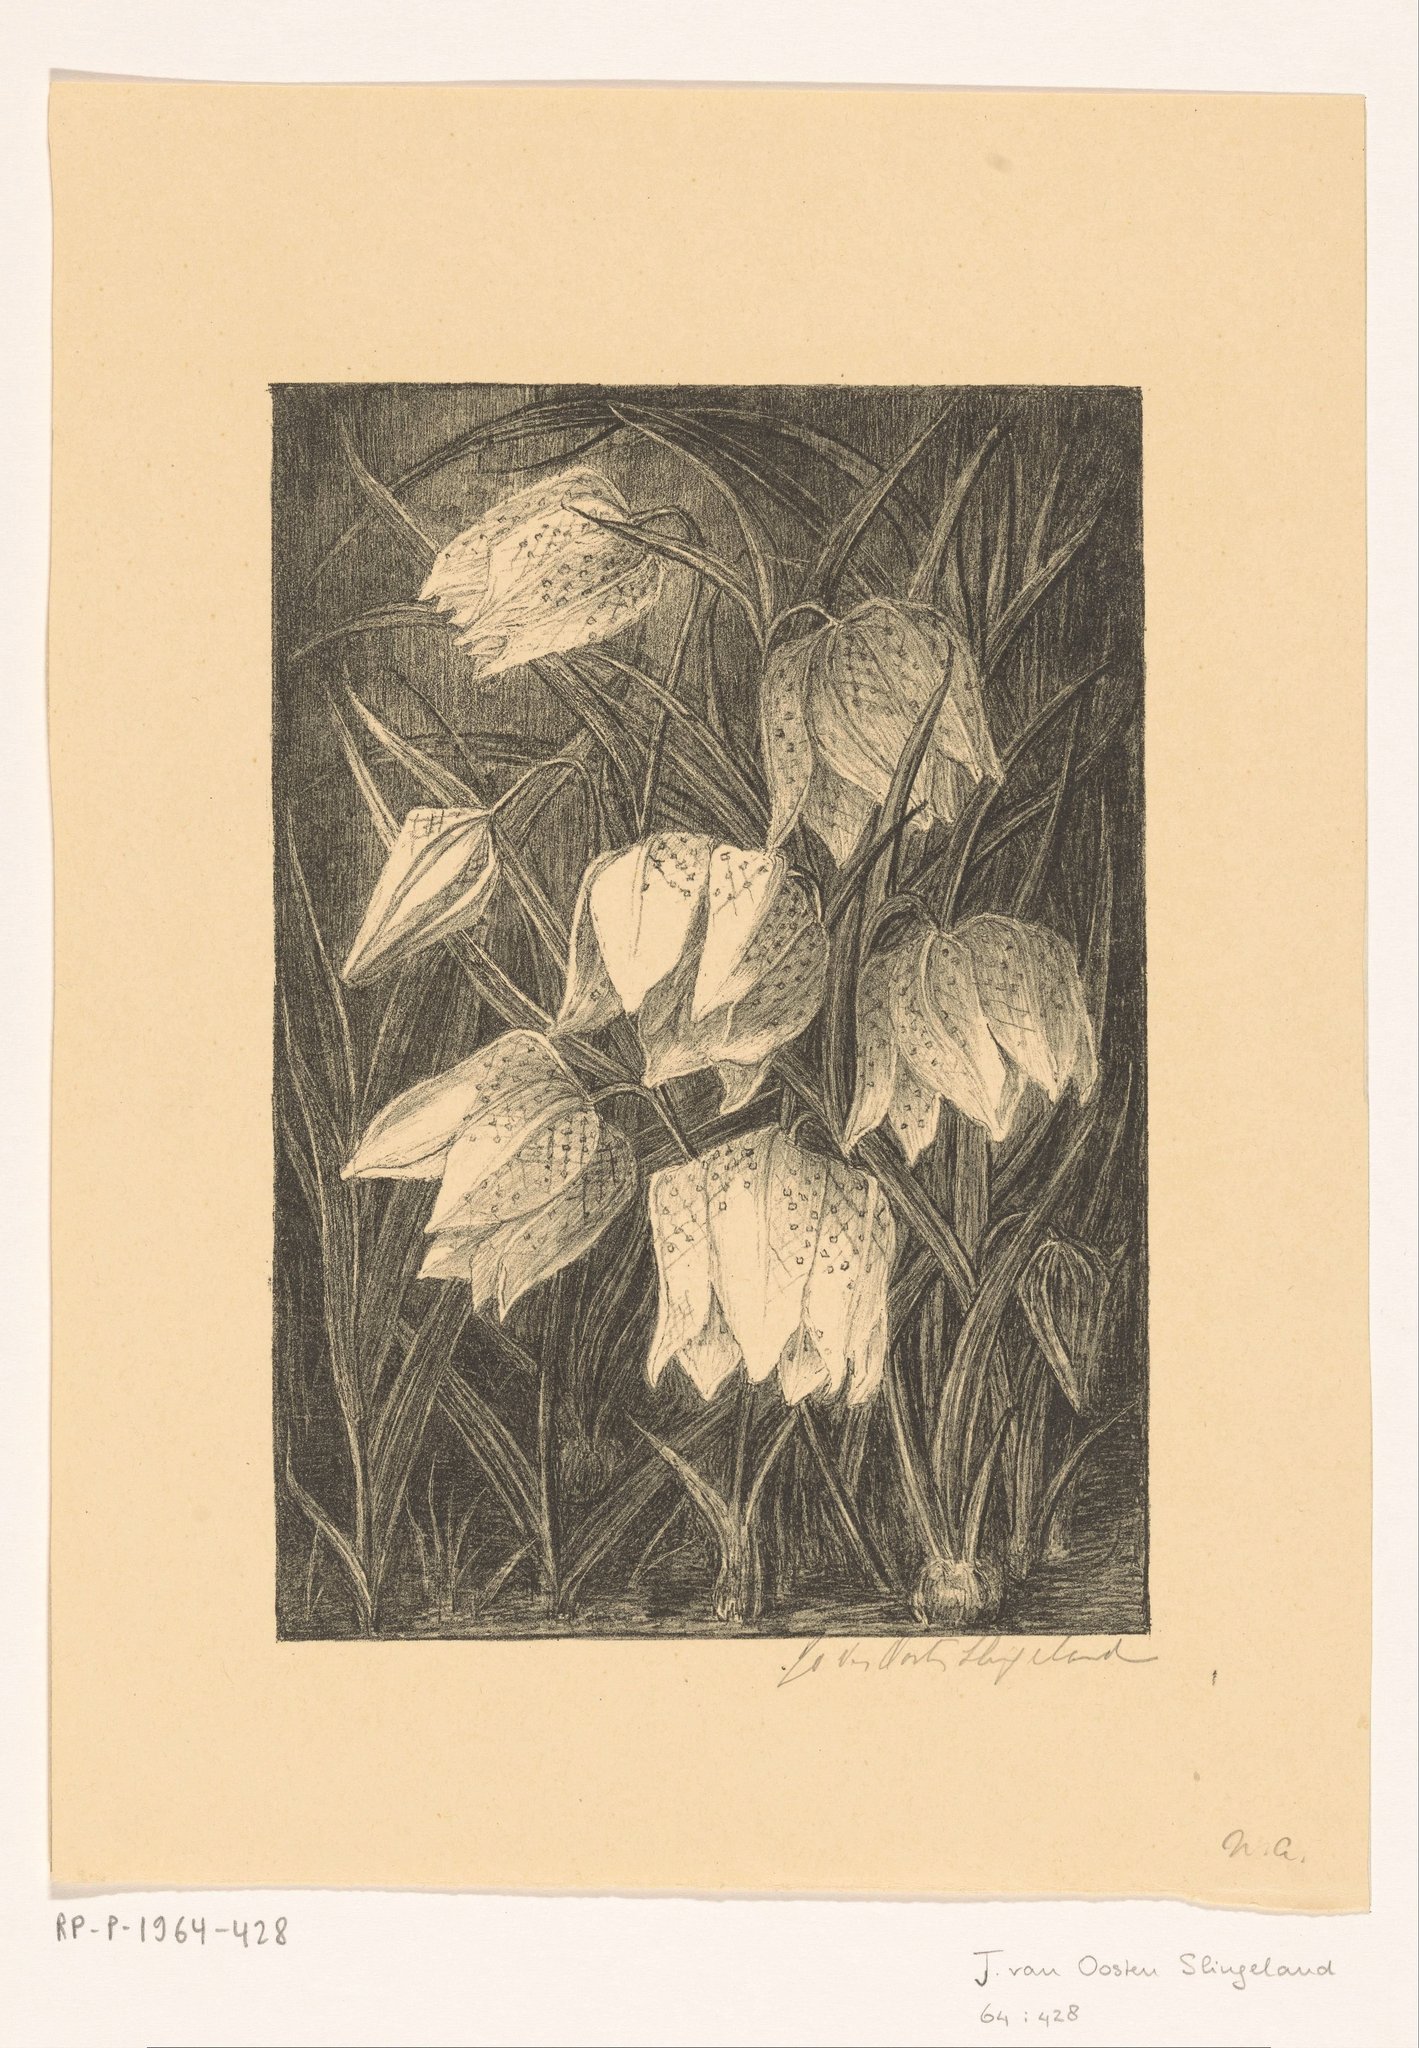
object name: print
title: Kievitsbloemen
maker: jo van oosten slingeland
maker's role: draughtsman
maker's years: 1877-1945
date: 1887-1945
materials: paper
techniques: lithograph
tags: flowers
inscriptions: collector's mark: Lugt 2228, inscription: ‘n.a.’